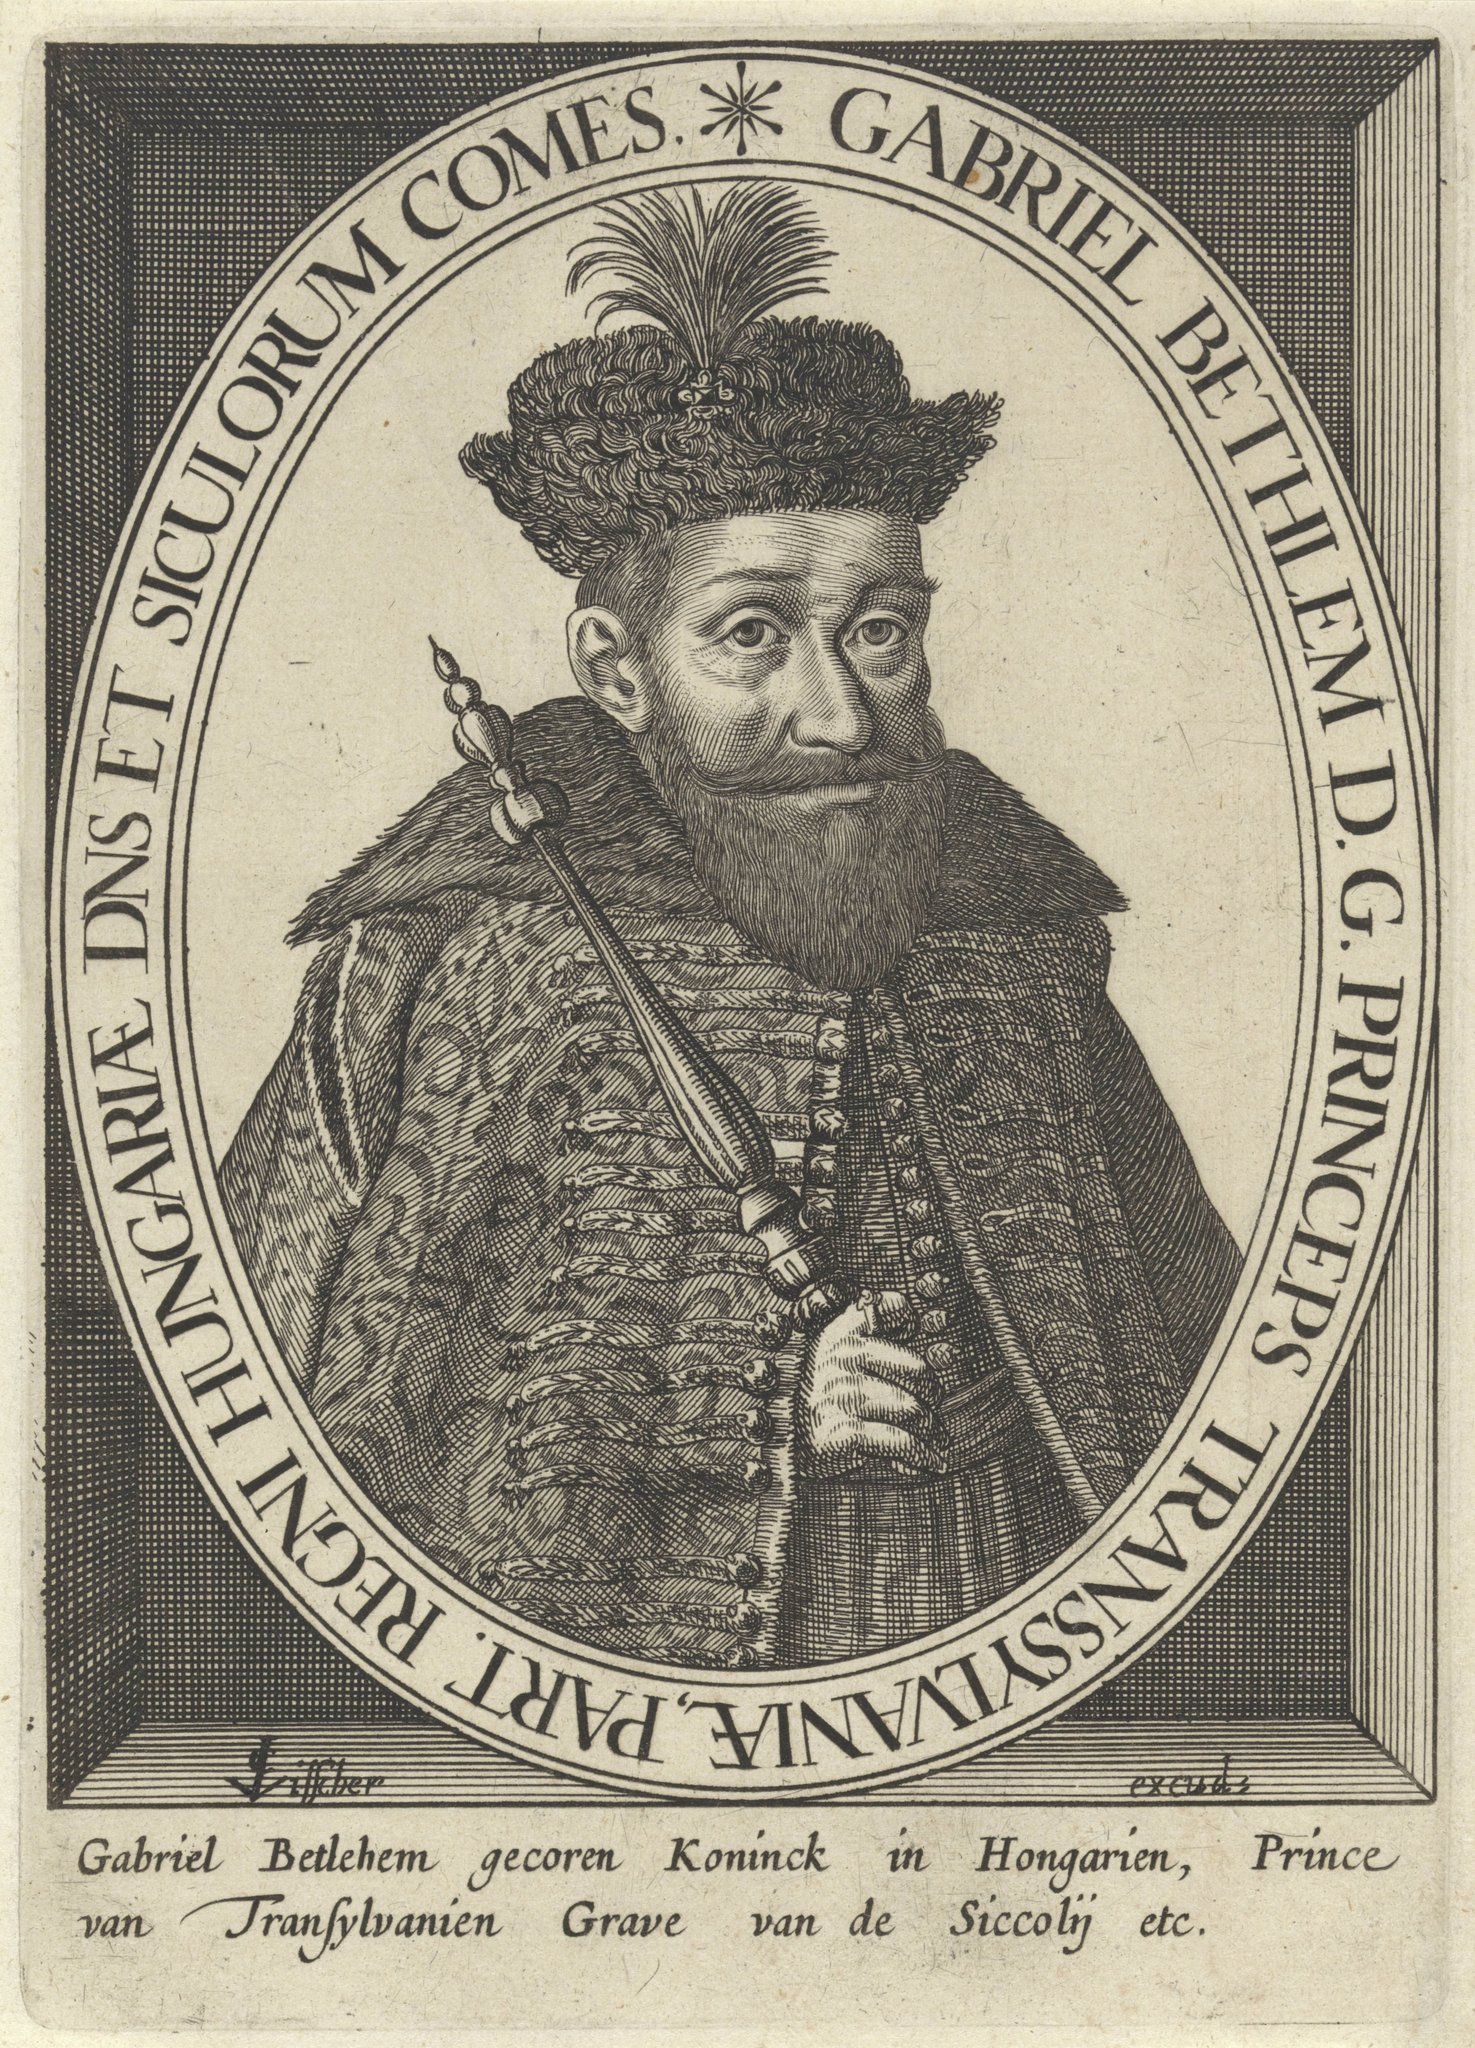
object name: print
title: Portret van Gabriel Bethlem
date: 1612-1652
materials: paper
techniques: engraving, etching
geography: amsterdam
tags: head-gear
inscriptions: collector's mark: Lugt 2228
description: Gabriel Bethlem, prins van Transsylvanië, met een scepter in zijn hand. Zijn portret is gevat in een ovale omlijsting waarin zijn naam en titels staan.